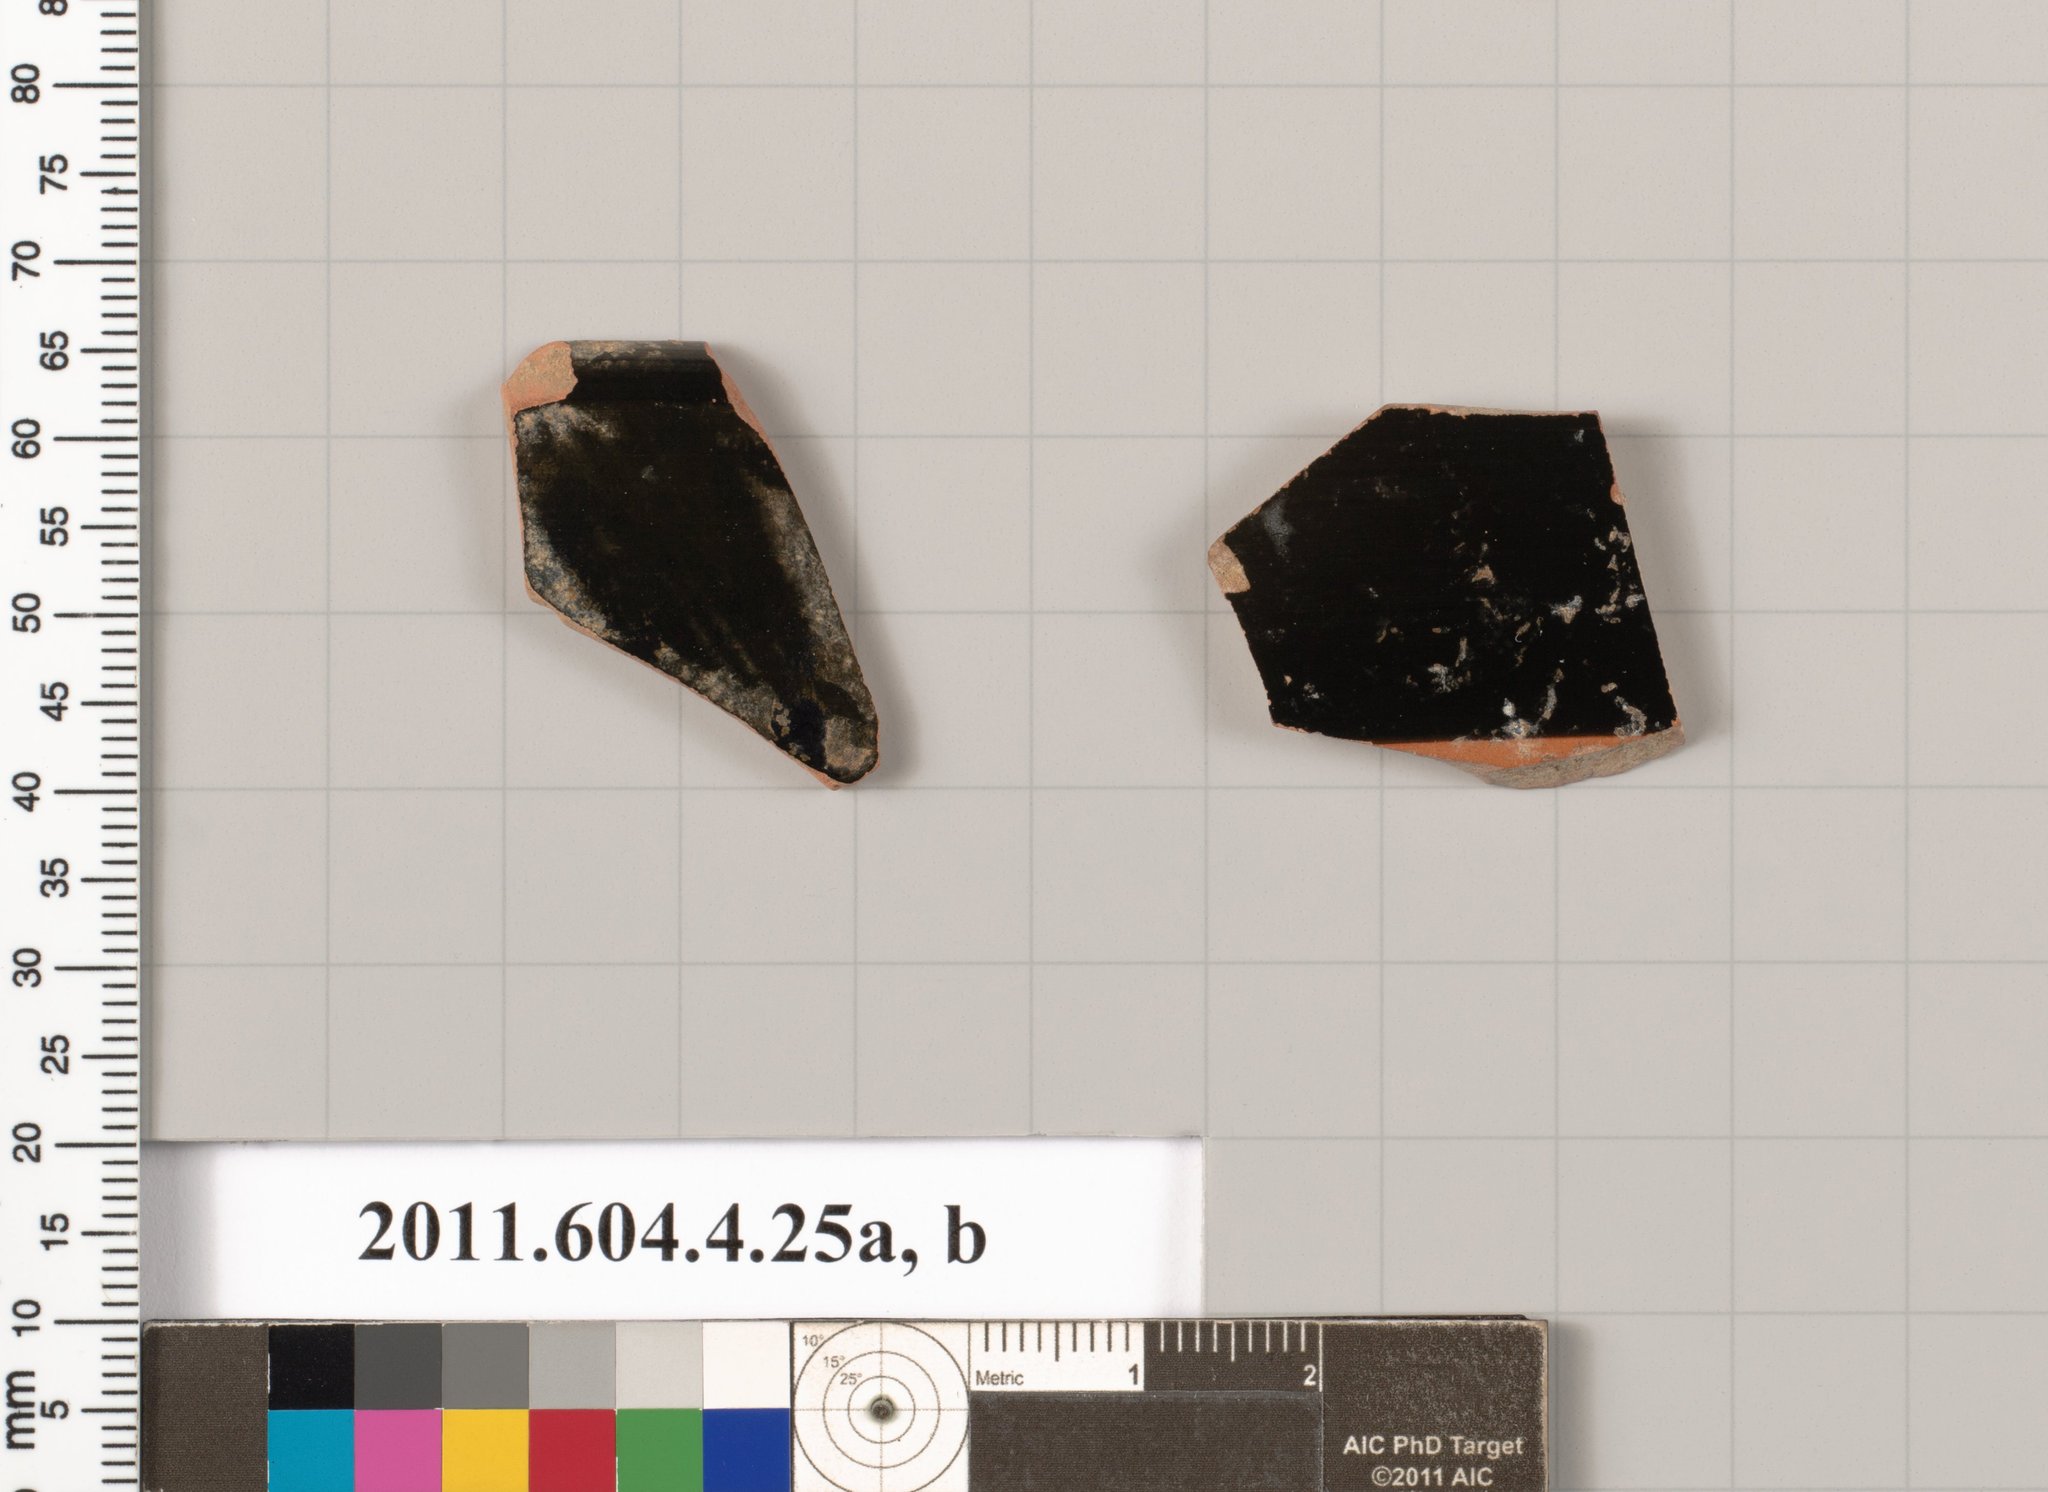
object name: kylix fragment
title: Terracotta fragments of a kylix (drinking cup)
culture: greek, attic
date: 500-401 BCE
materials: terracotta